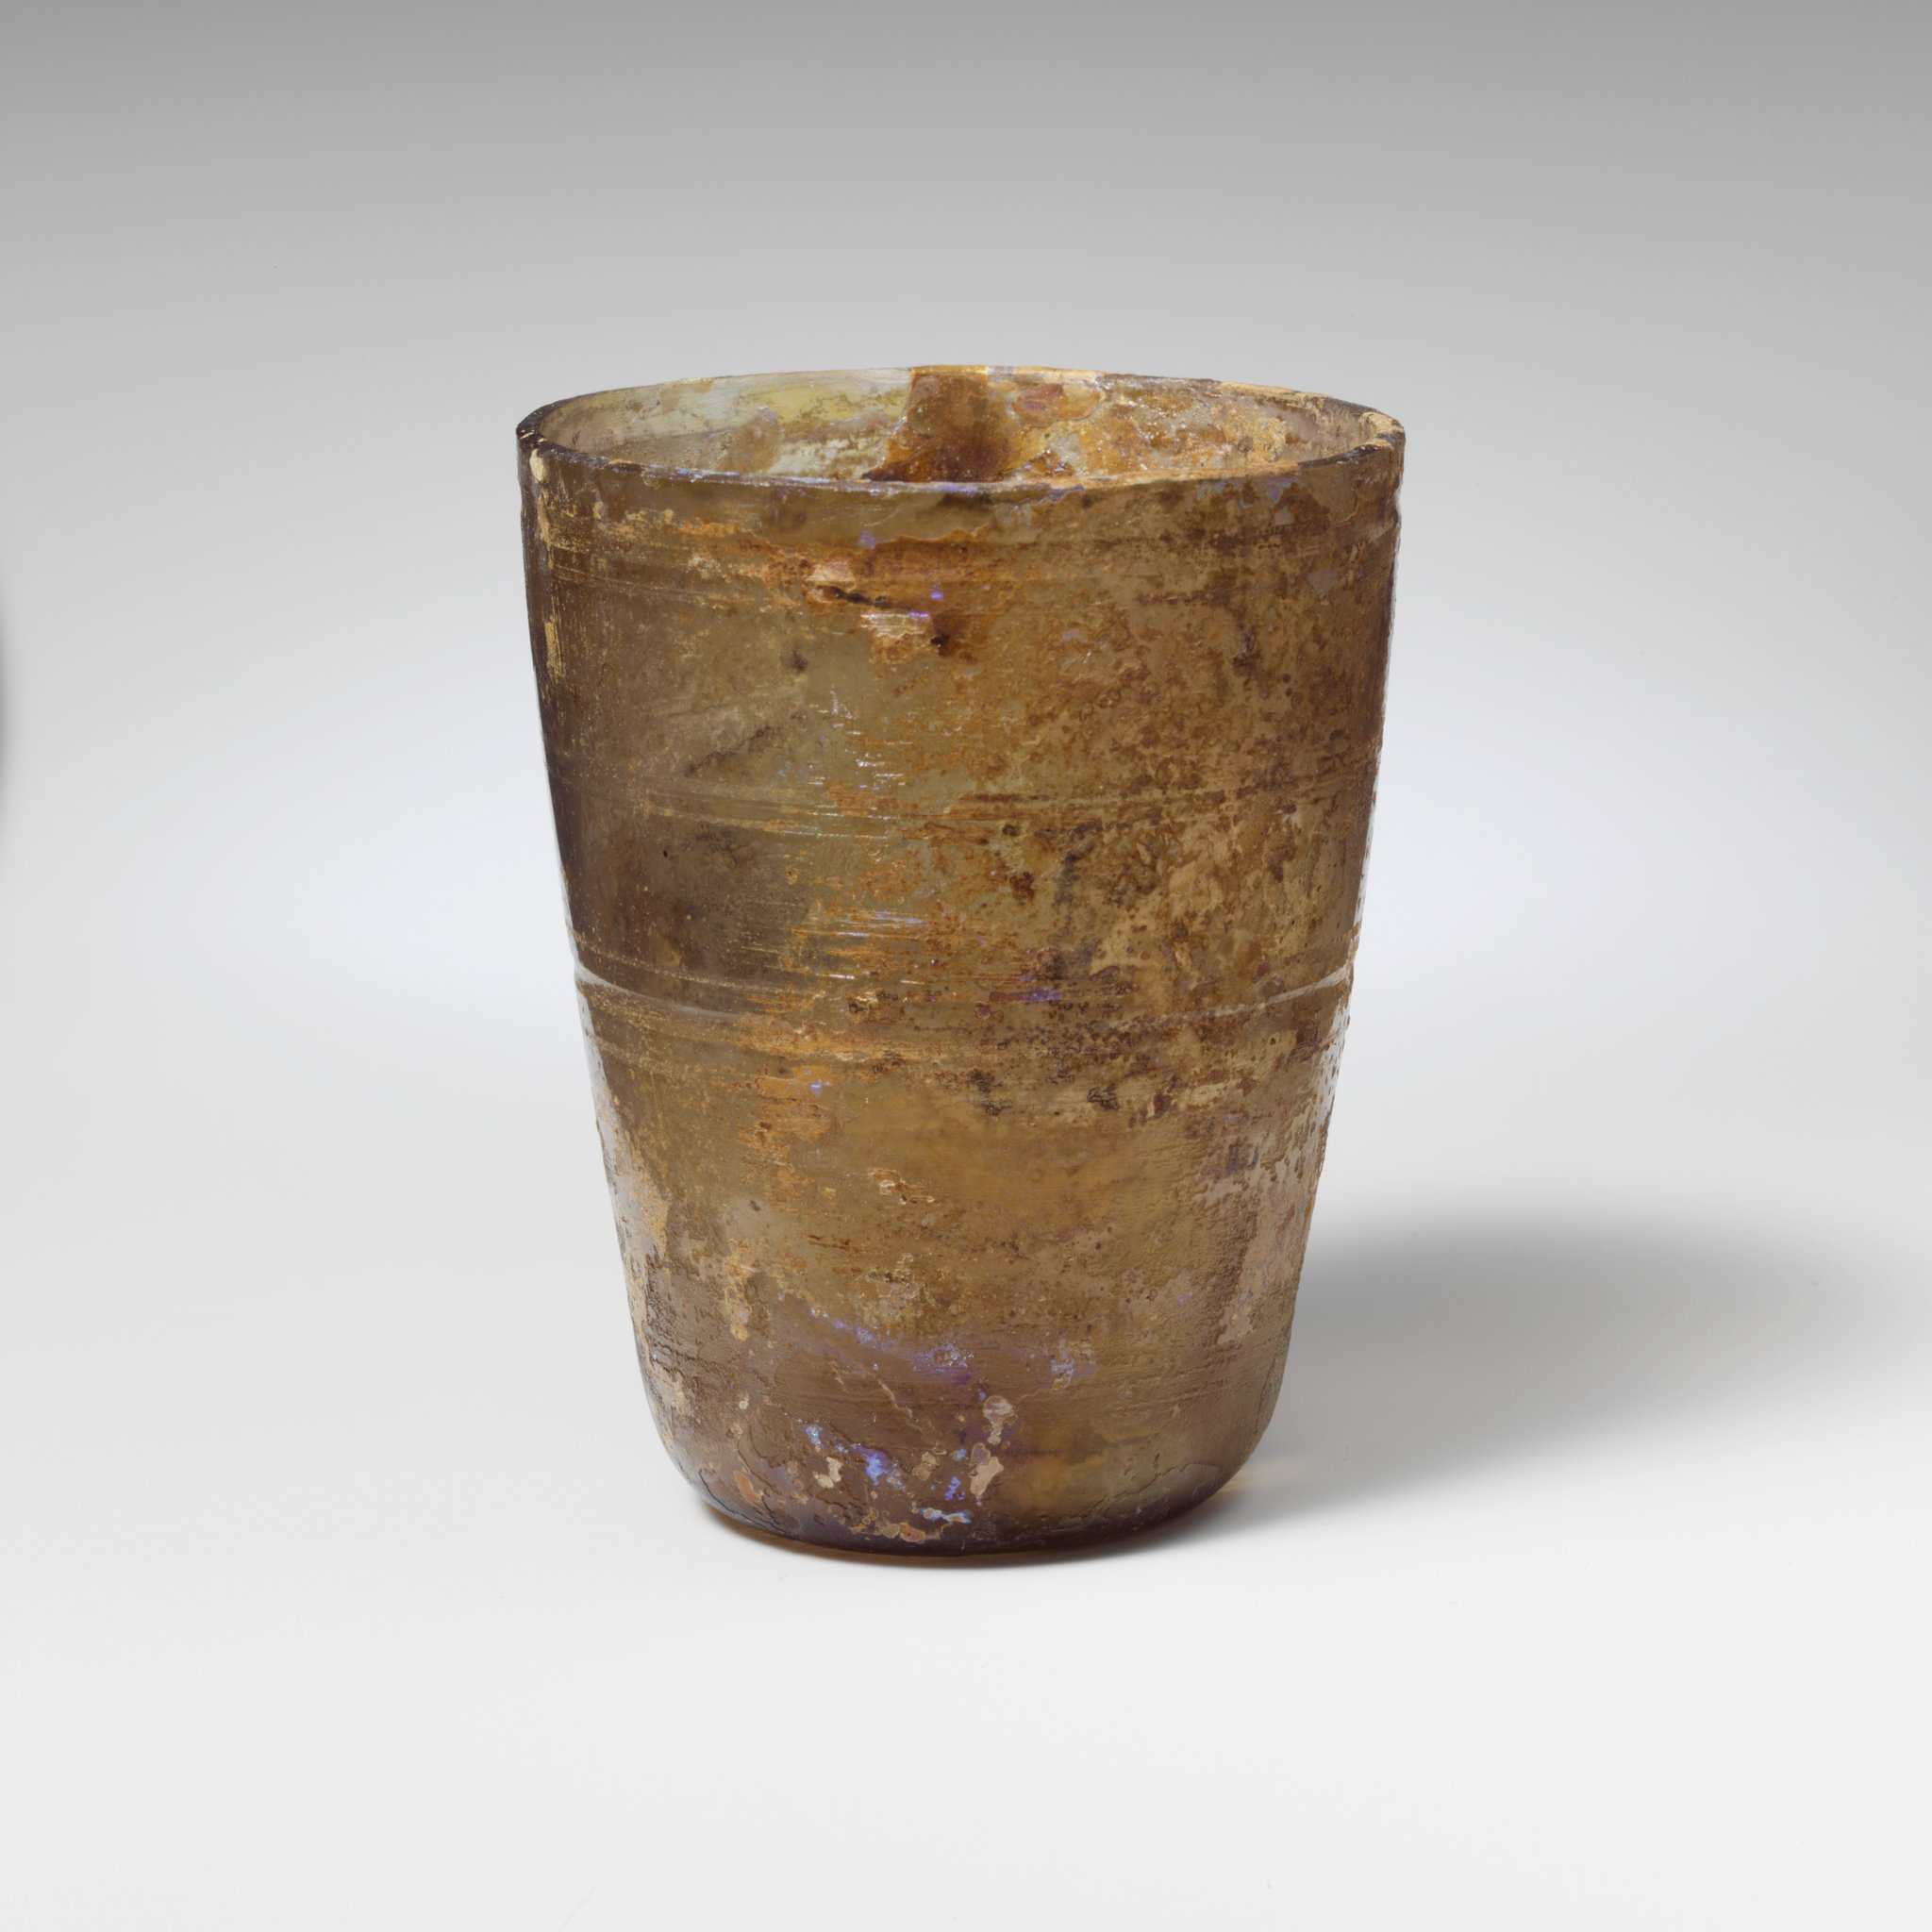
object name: beaker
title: Glass beaker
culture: roman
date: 1-100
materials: glass